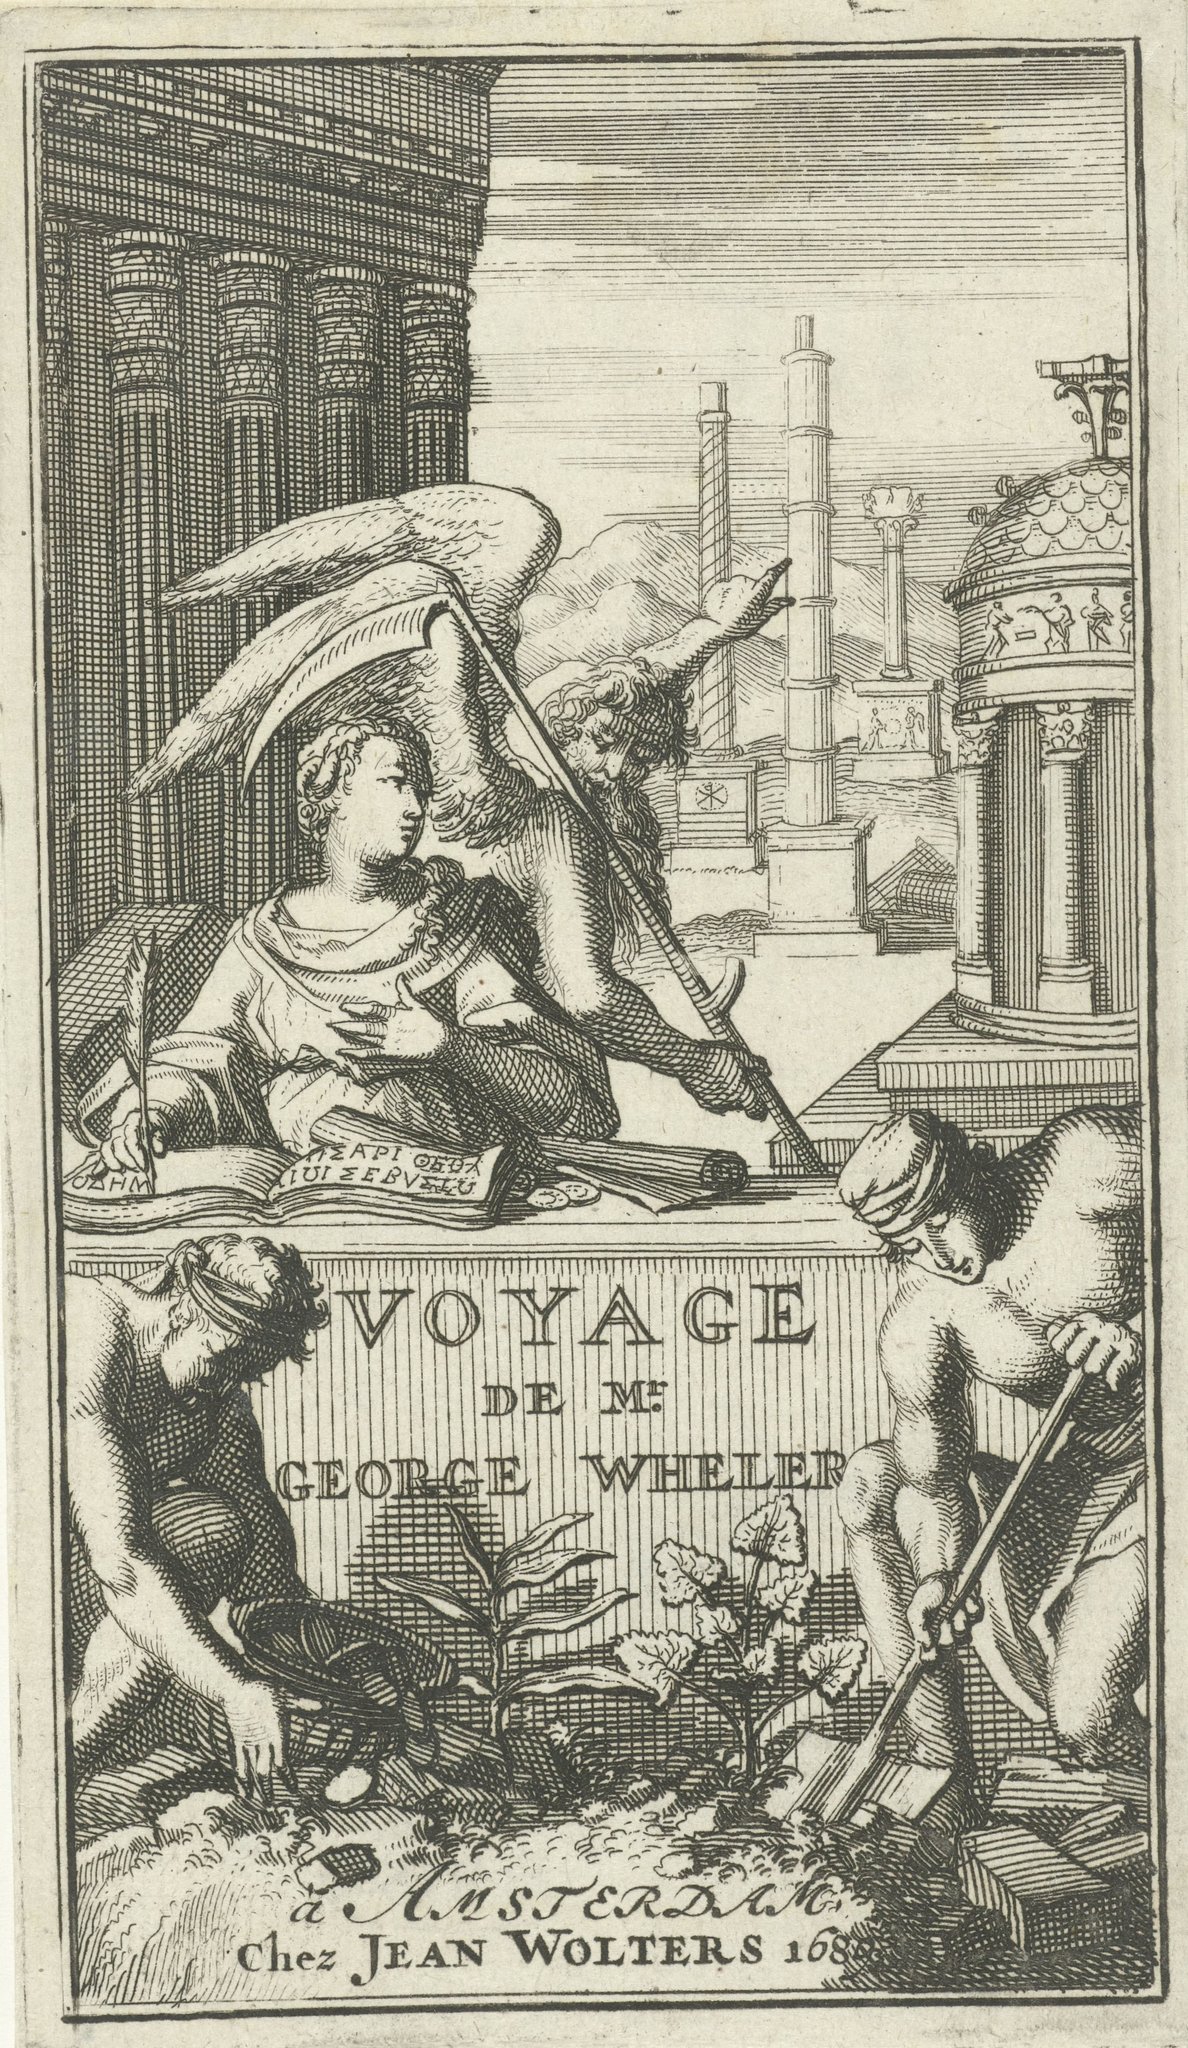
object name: print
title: Vader Tijd wijst schrijvende vrouw op monumenten uit de klassieke oudheid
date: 1689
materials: paper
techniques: etching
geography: amsterdam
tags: greek script, author, poet writing, father time, man with wings and scythe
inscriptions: collector's mark: Lugt 2228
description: Titelpagina voor: Spon, Jacob en George Wheler. Voyagie de Dalmatie, de Grece, et du Levant, 2 delen. Amsterdam: Joannes Wolters, 1689.